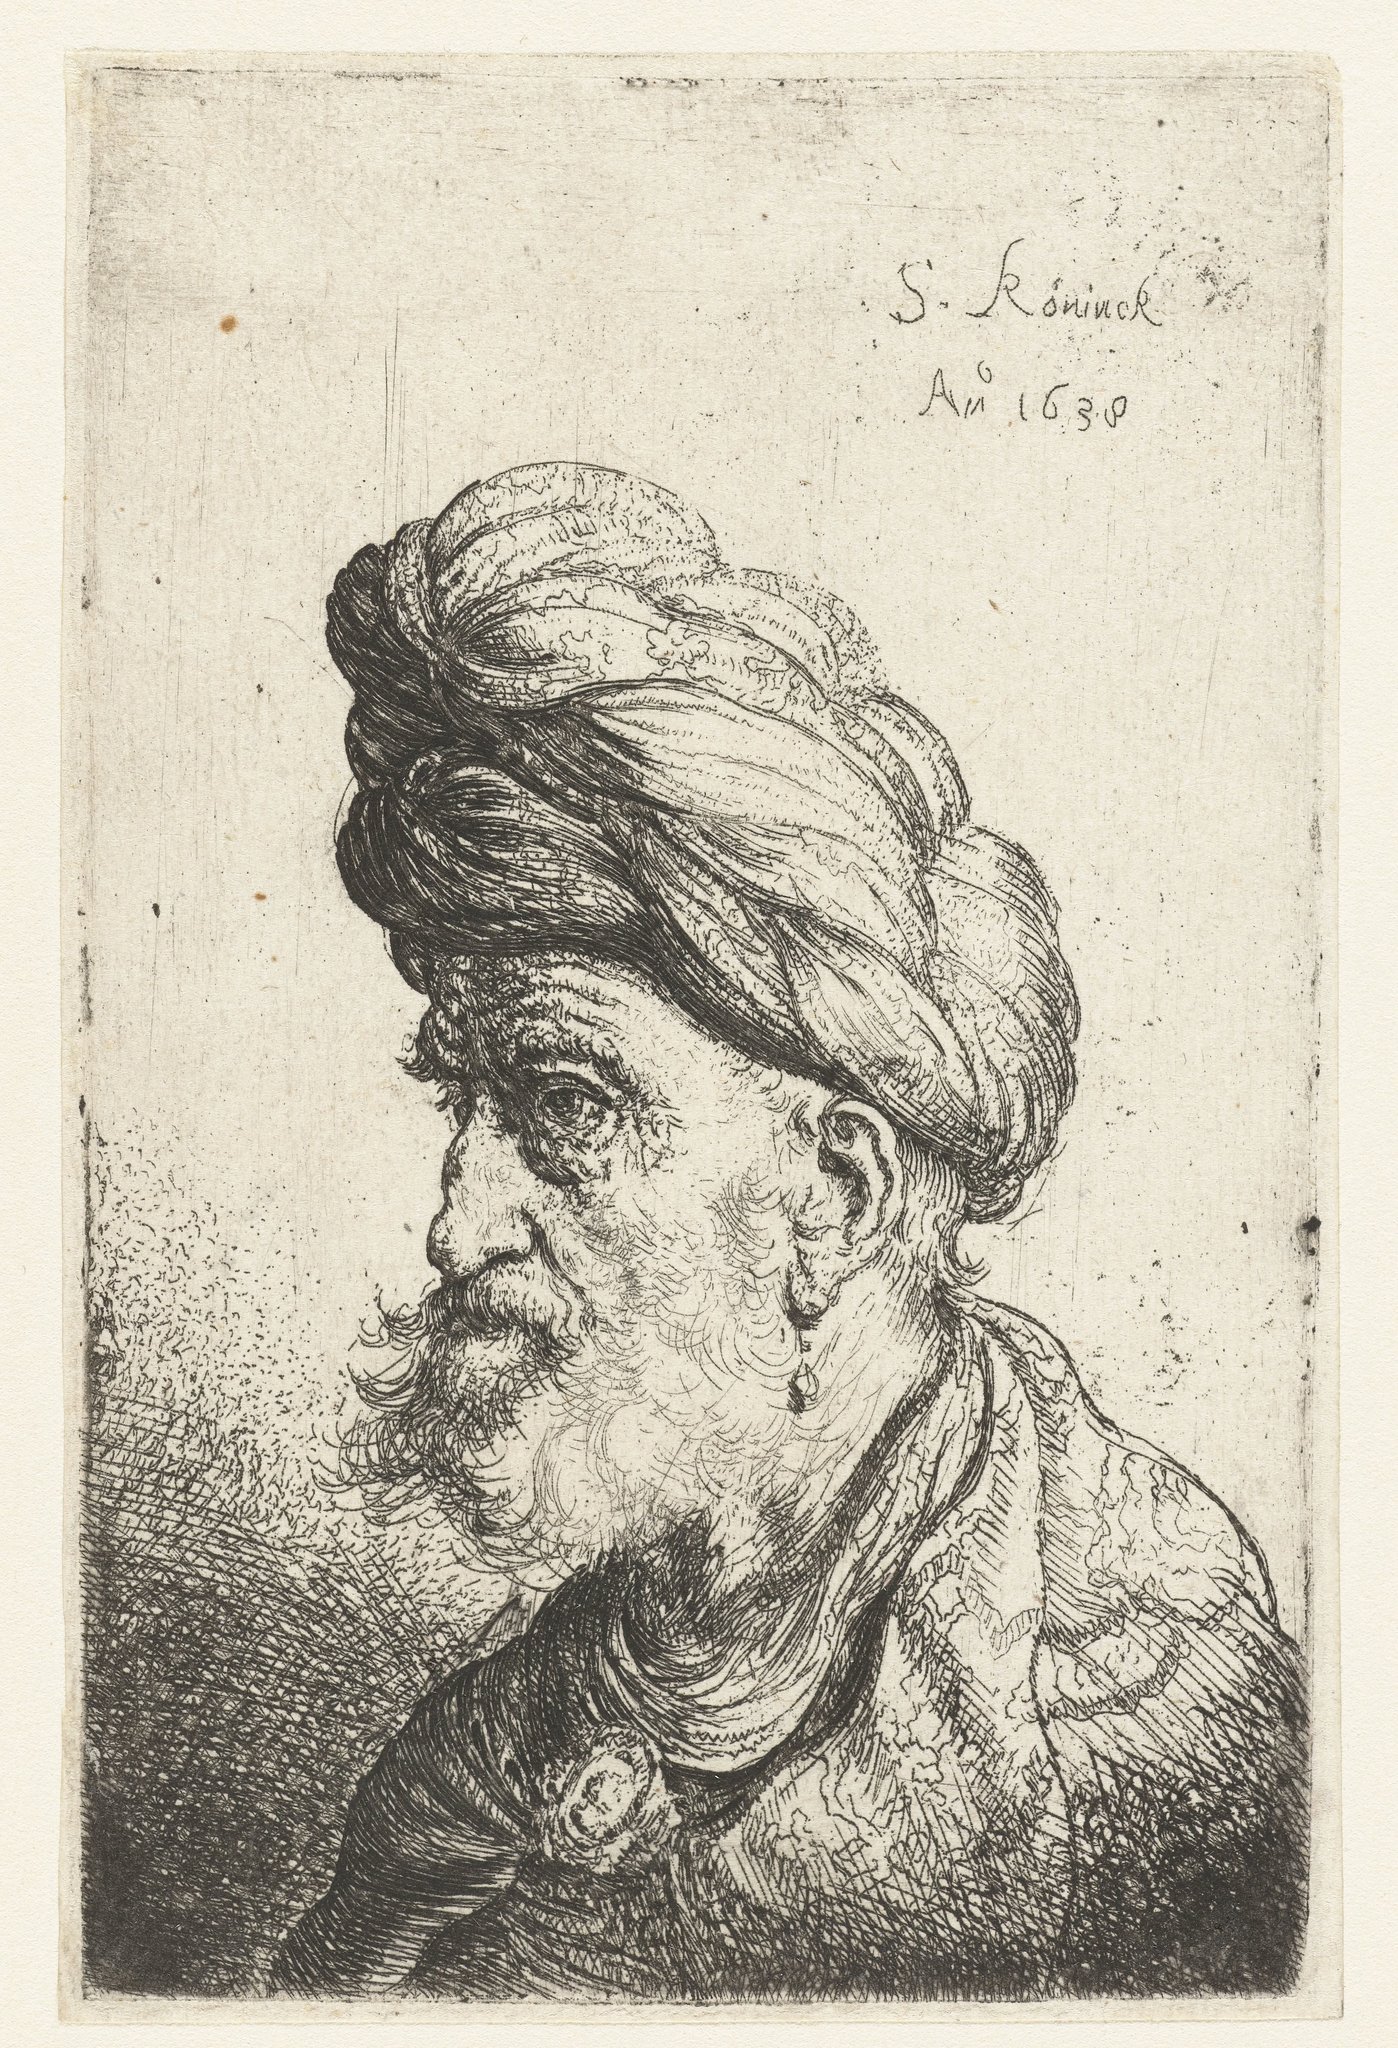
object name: print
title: Buste van een man met tulband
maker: salomon koninck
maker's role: draughtsman, painter, print maker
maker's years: 1609-1656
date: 1638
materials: paper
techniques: etching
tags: old man, head-gear: turban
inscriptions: collector's mark: Lugt 240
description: Buste van een oude man met een baard, een hoge tulband en een oorbel.